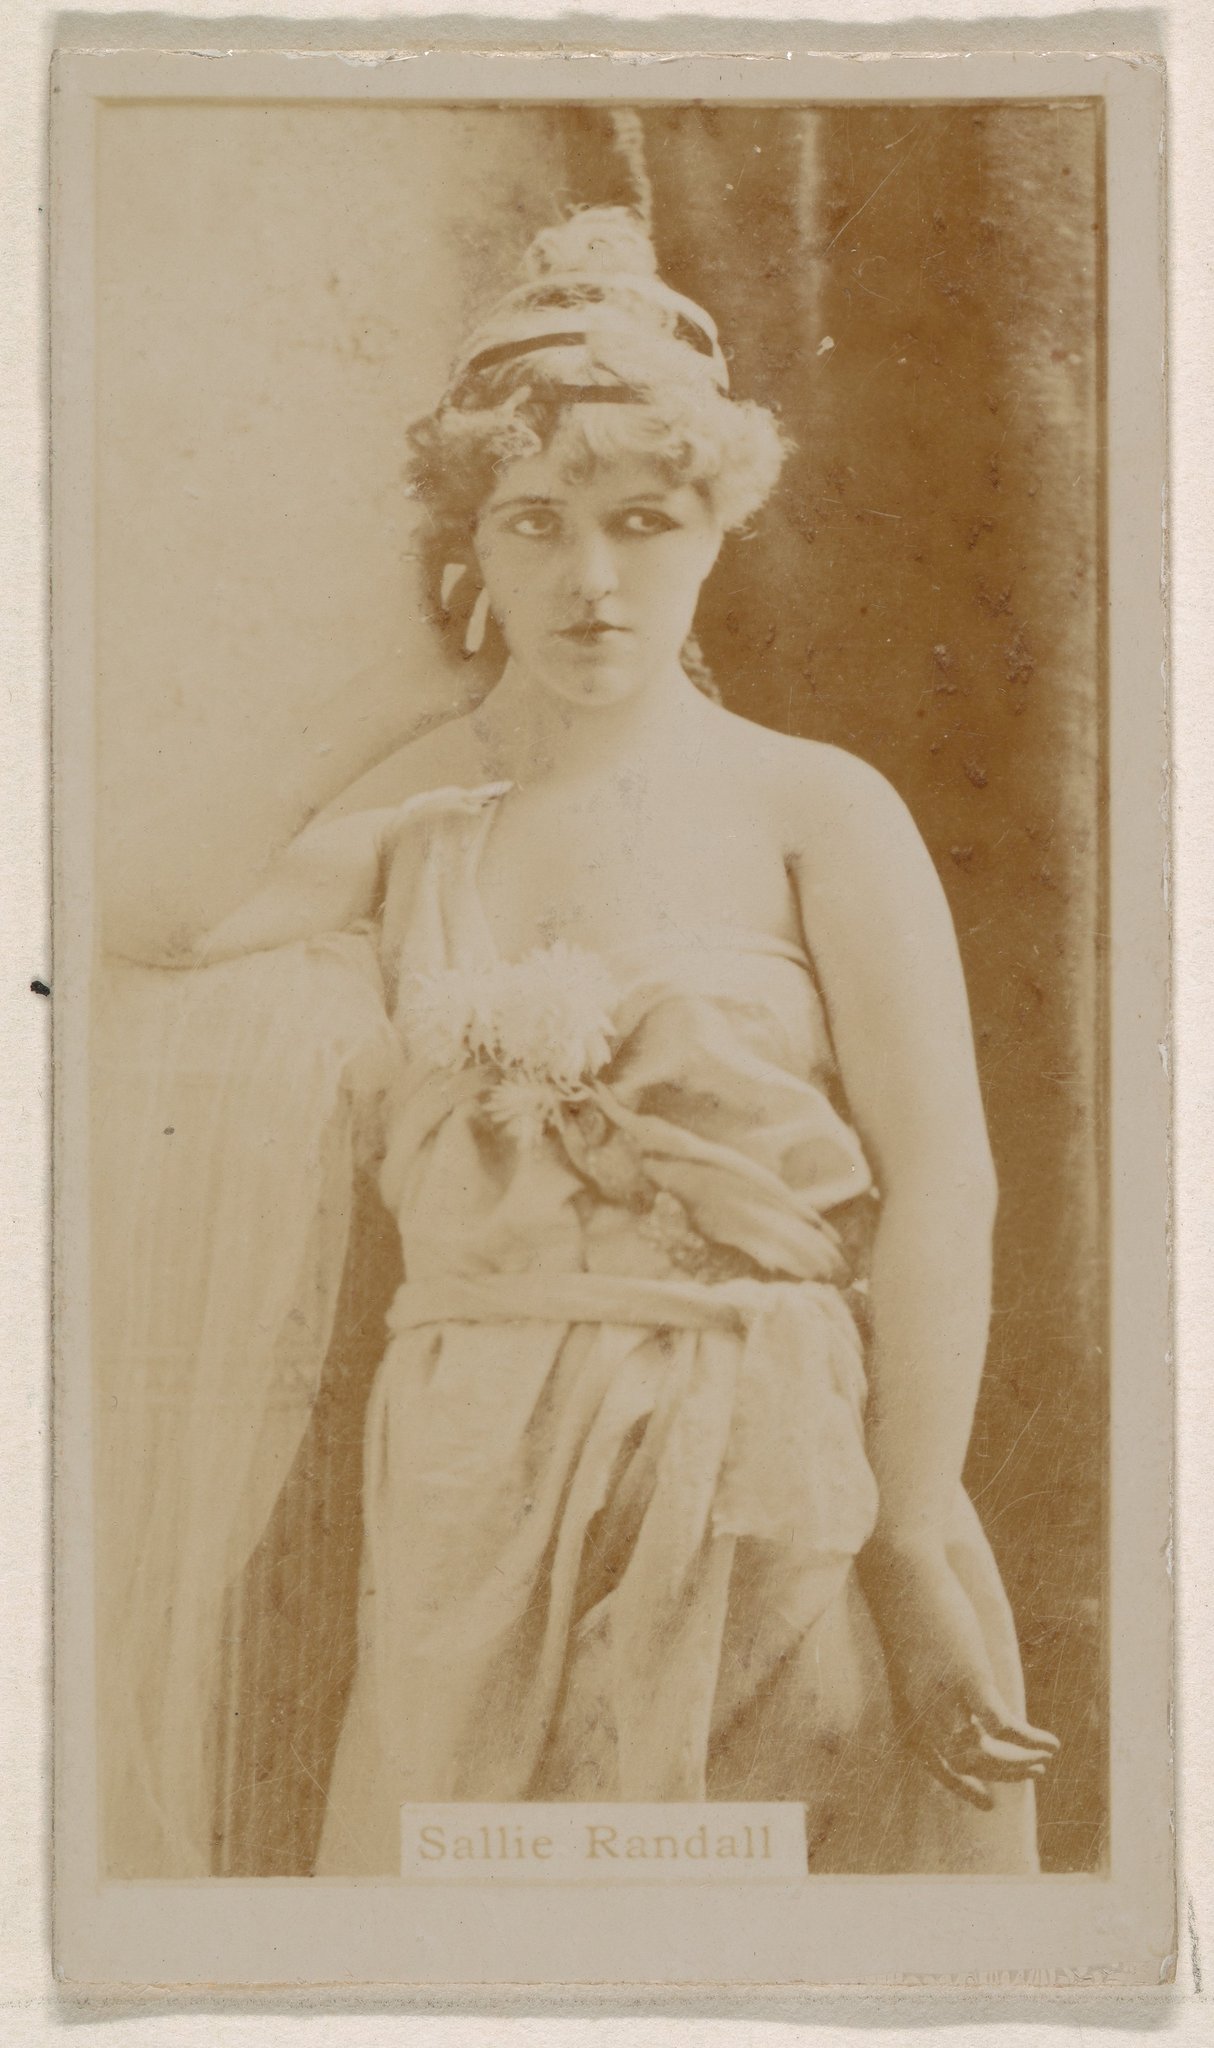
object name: photograph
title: Sallie Randall, from the Actresses series (N245) issued by Kinney Brothers to promote Sweet Caporal Cigarettes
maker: kinney brothers tobacco company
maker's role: publisher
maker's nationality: american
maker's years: 1869-2011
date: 1890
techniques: albumen silver print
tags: portraits,women,actresses